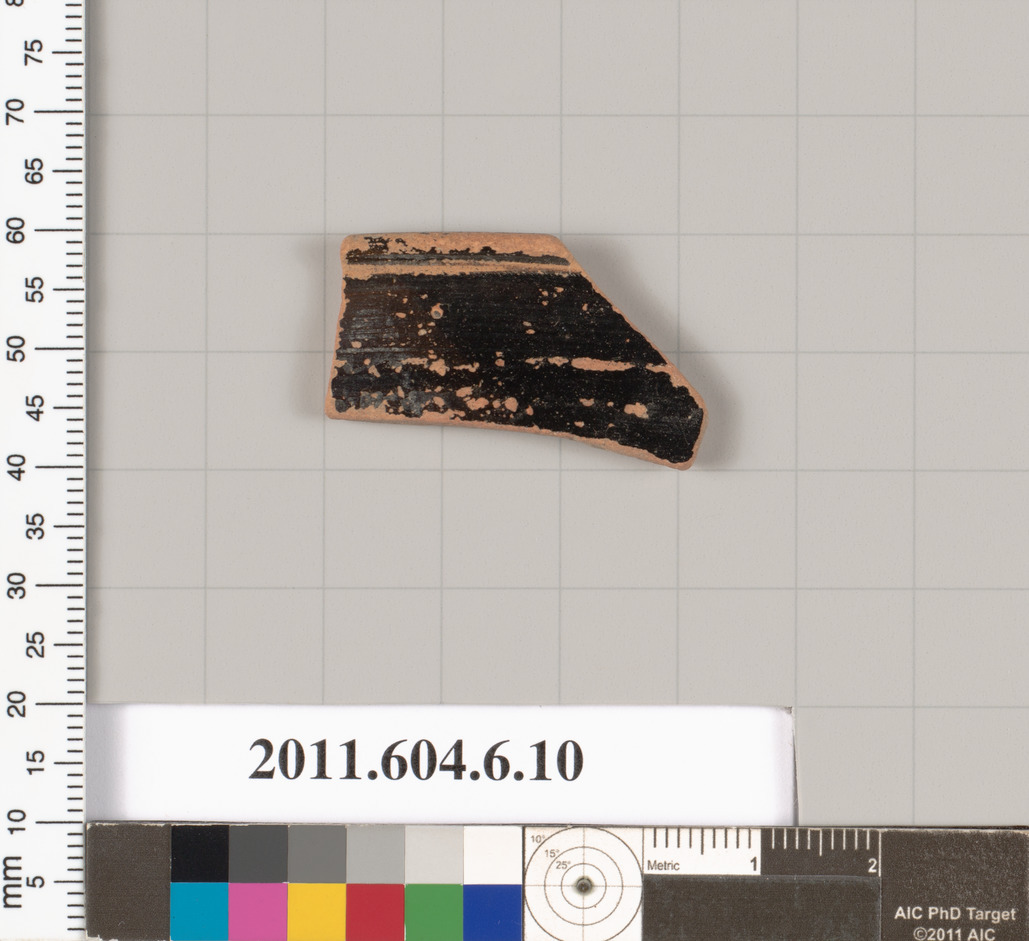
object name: undetermined open shape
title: Terracotta rim fragment of an open shape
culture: greek, attic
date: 600-401 BCE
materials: terracotta